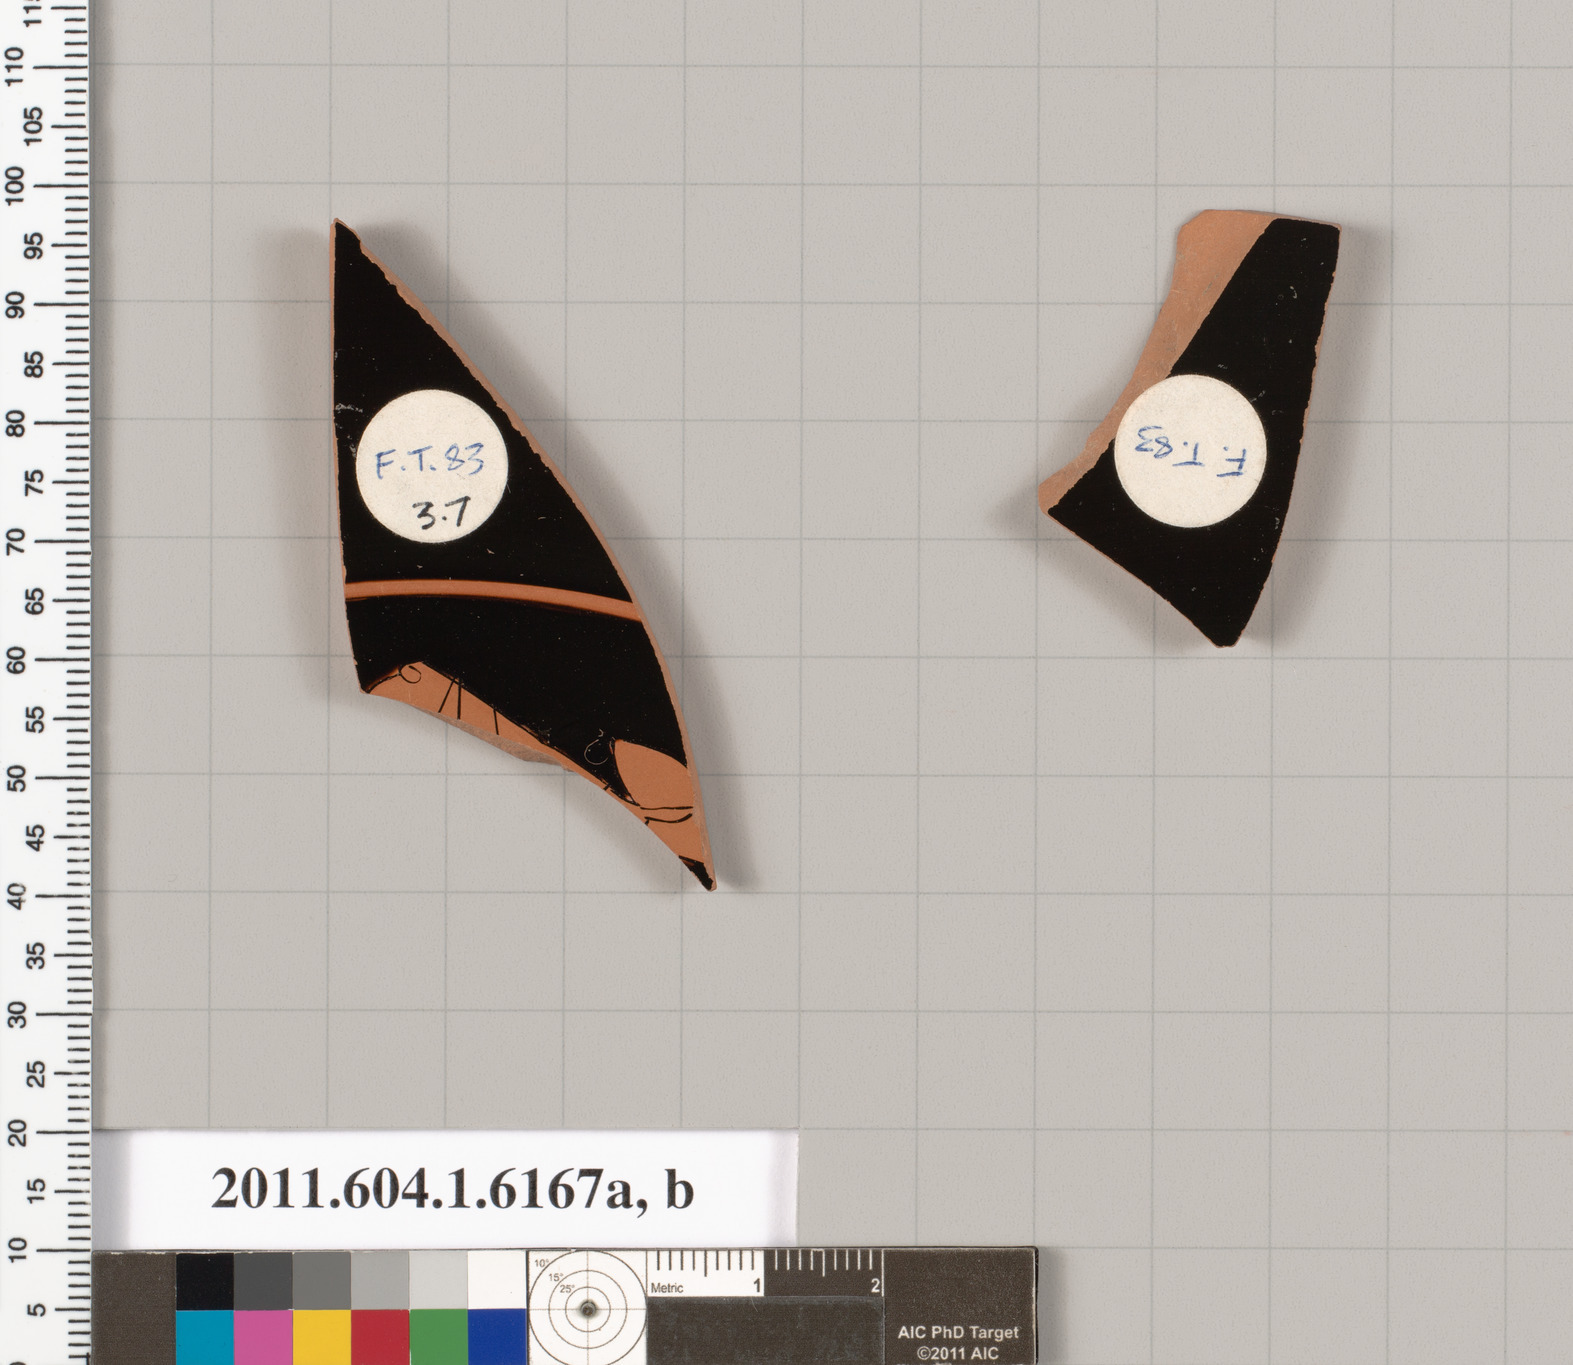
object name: kylix fragment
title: Terracotta fragments of a kylix (drinking cup)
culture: greek, attic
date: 520-500 BCE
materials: terracotta